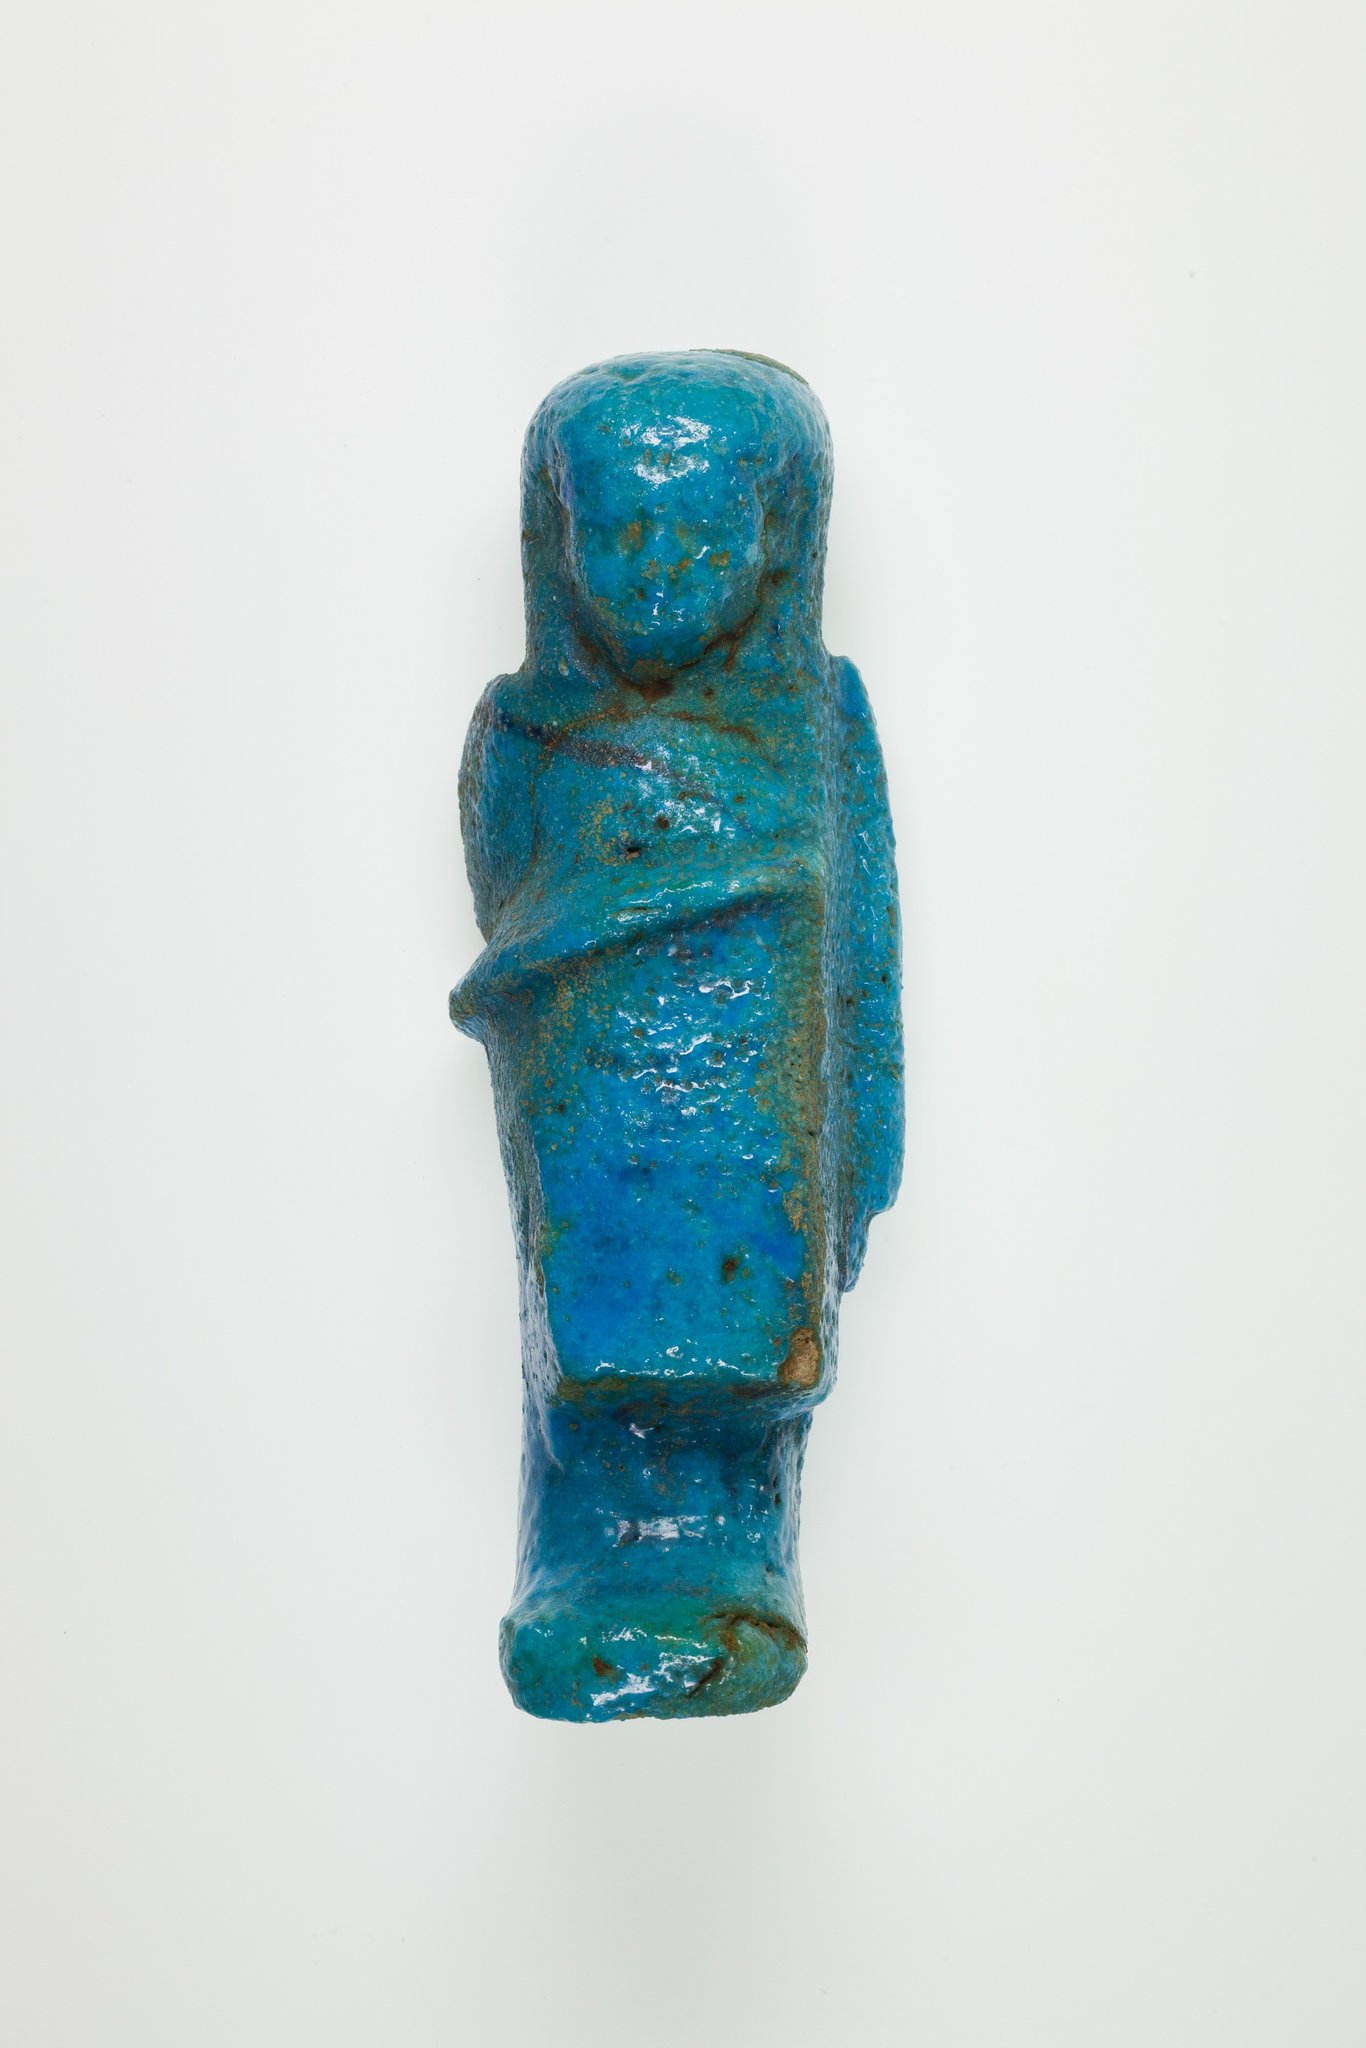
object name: overseer shabti, henettawy c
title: Overseer Shabti of Henettawy (C), Daughter of Isetemkheb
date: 990-970 BCE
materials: faience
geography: egypt